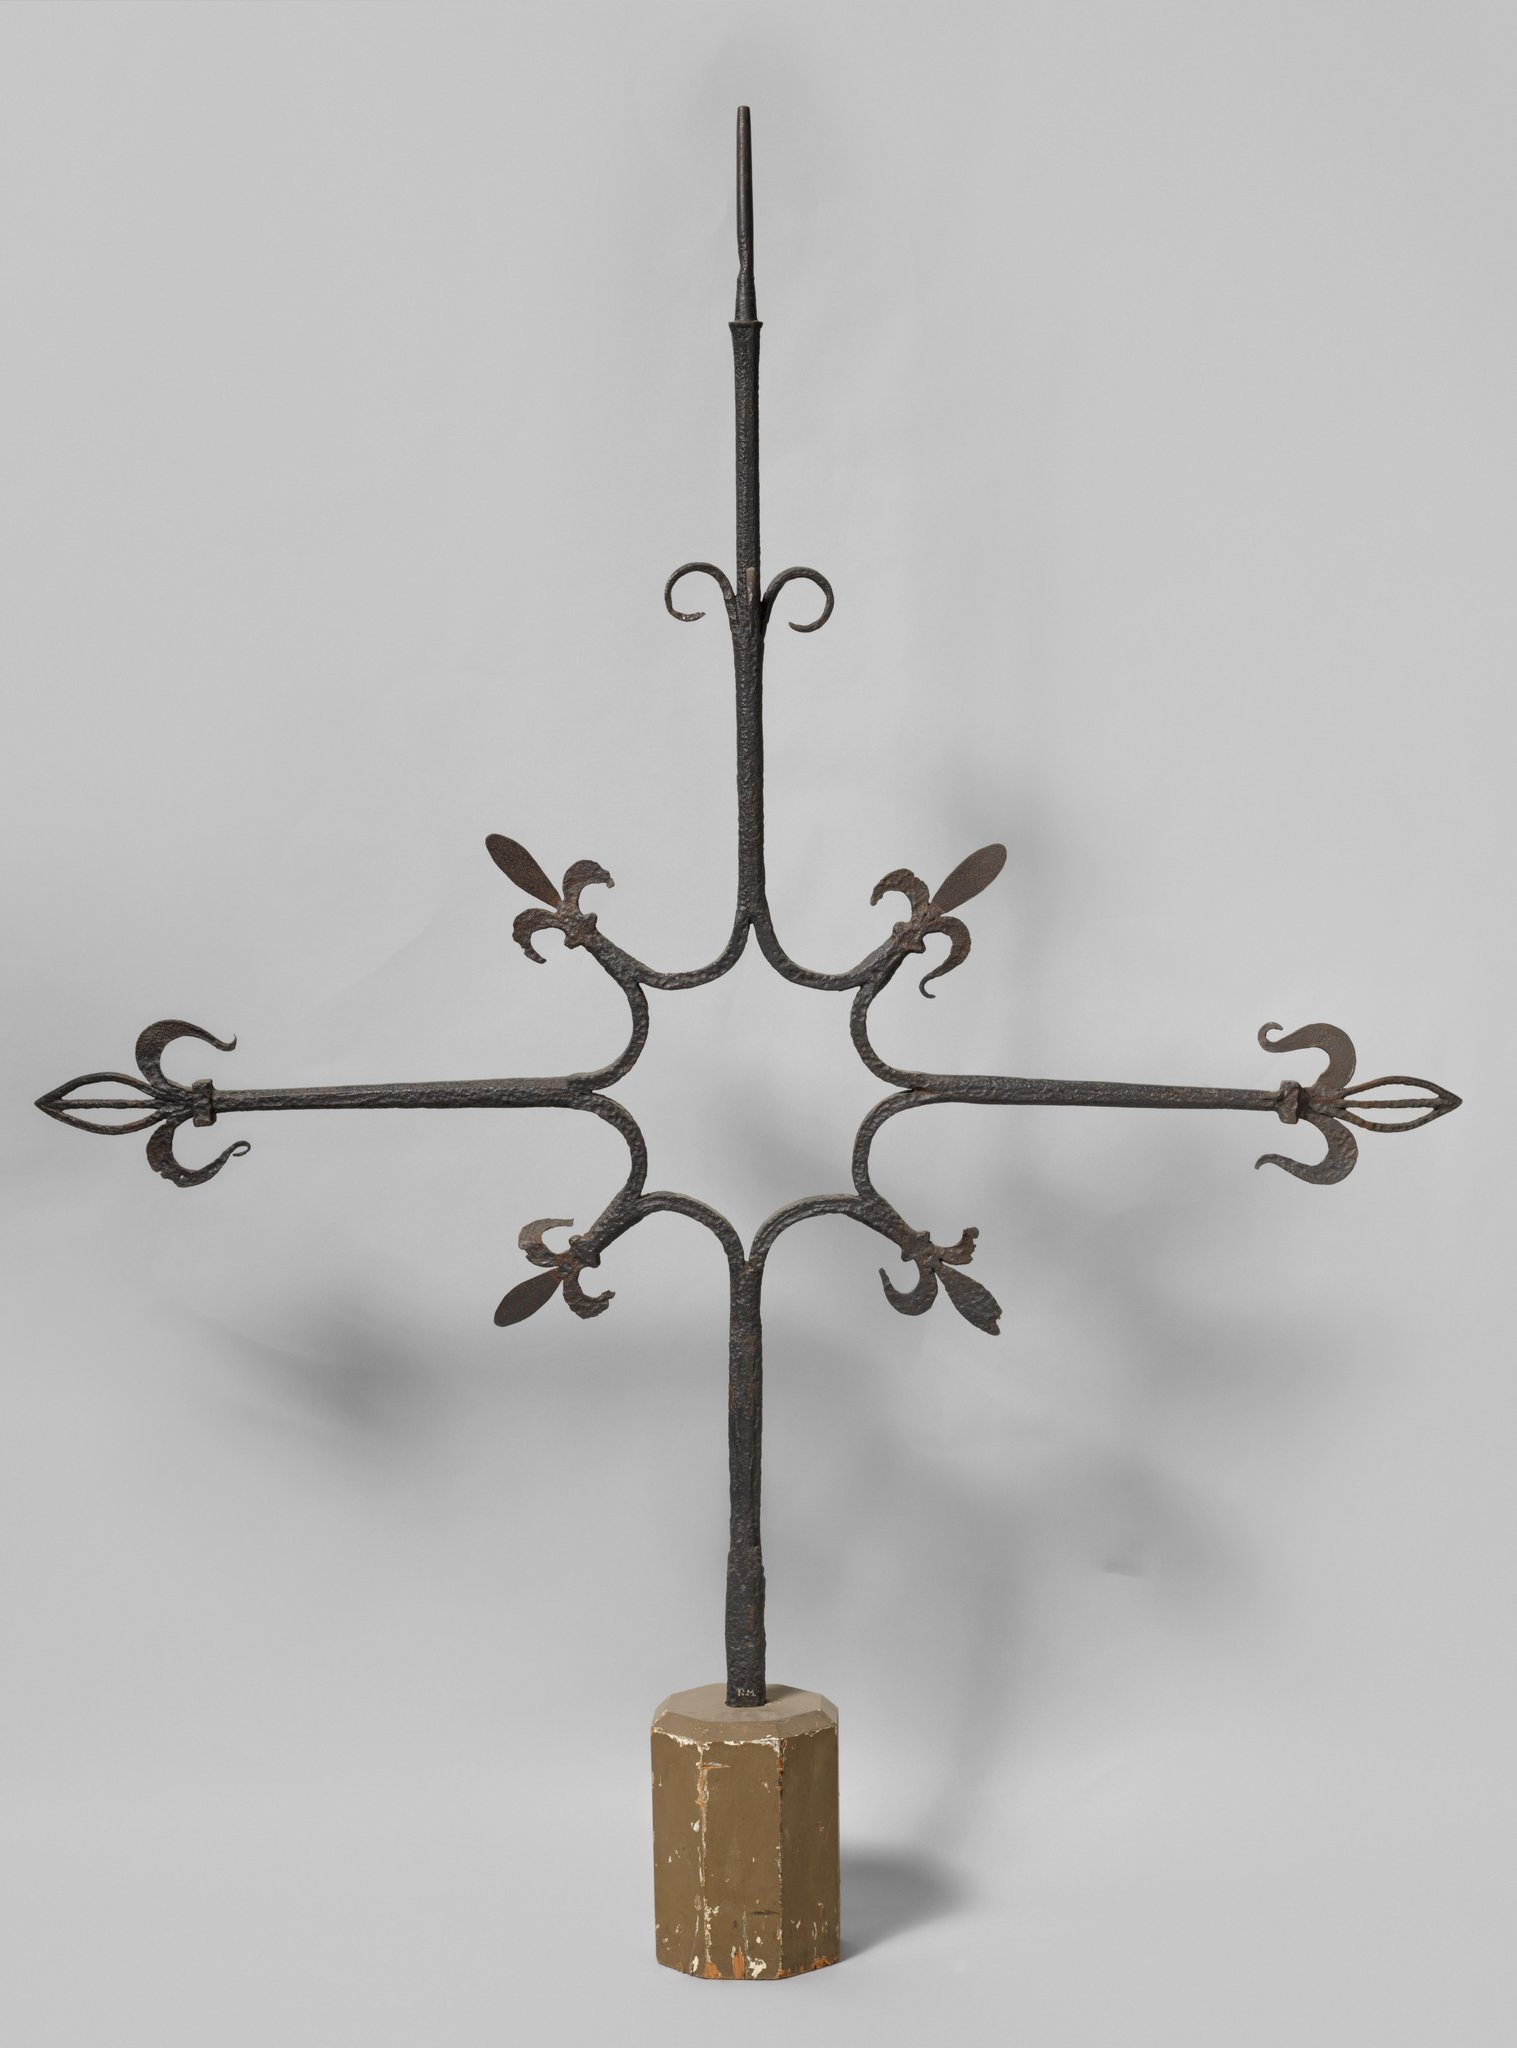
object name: torenkruis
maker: Anonymous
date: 1500-1524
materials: iron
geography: northern netherlands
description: Een torenkruis afkomstig van de NH kerk te Gorssel De, in het eerst vierkant en daarna achthoekig verlopende, schacht gaat over in een achthoek met naar binnen gebogen zijden uit welk hoeken de zij- en boven armen ontspringen. De laatste is versierd met vier naar beneden buigende punten en eindigt in een ronde spil voor een weerhaan. De zijarmen, evenals de overige hoeken van de achthoek, lopen in lelies uit. Aan drie lelies zit een vernieuwd kelkblad.